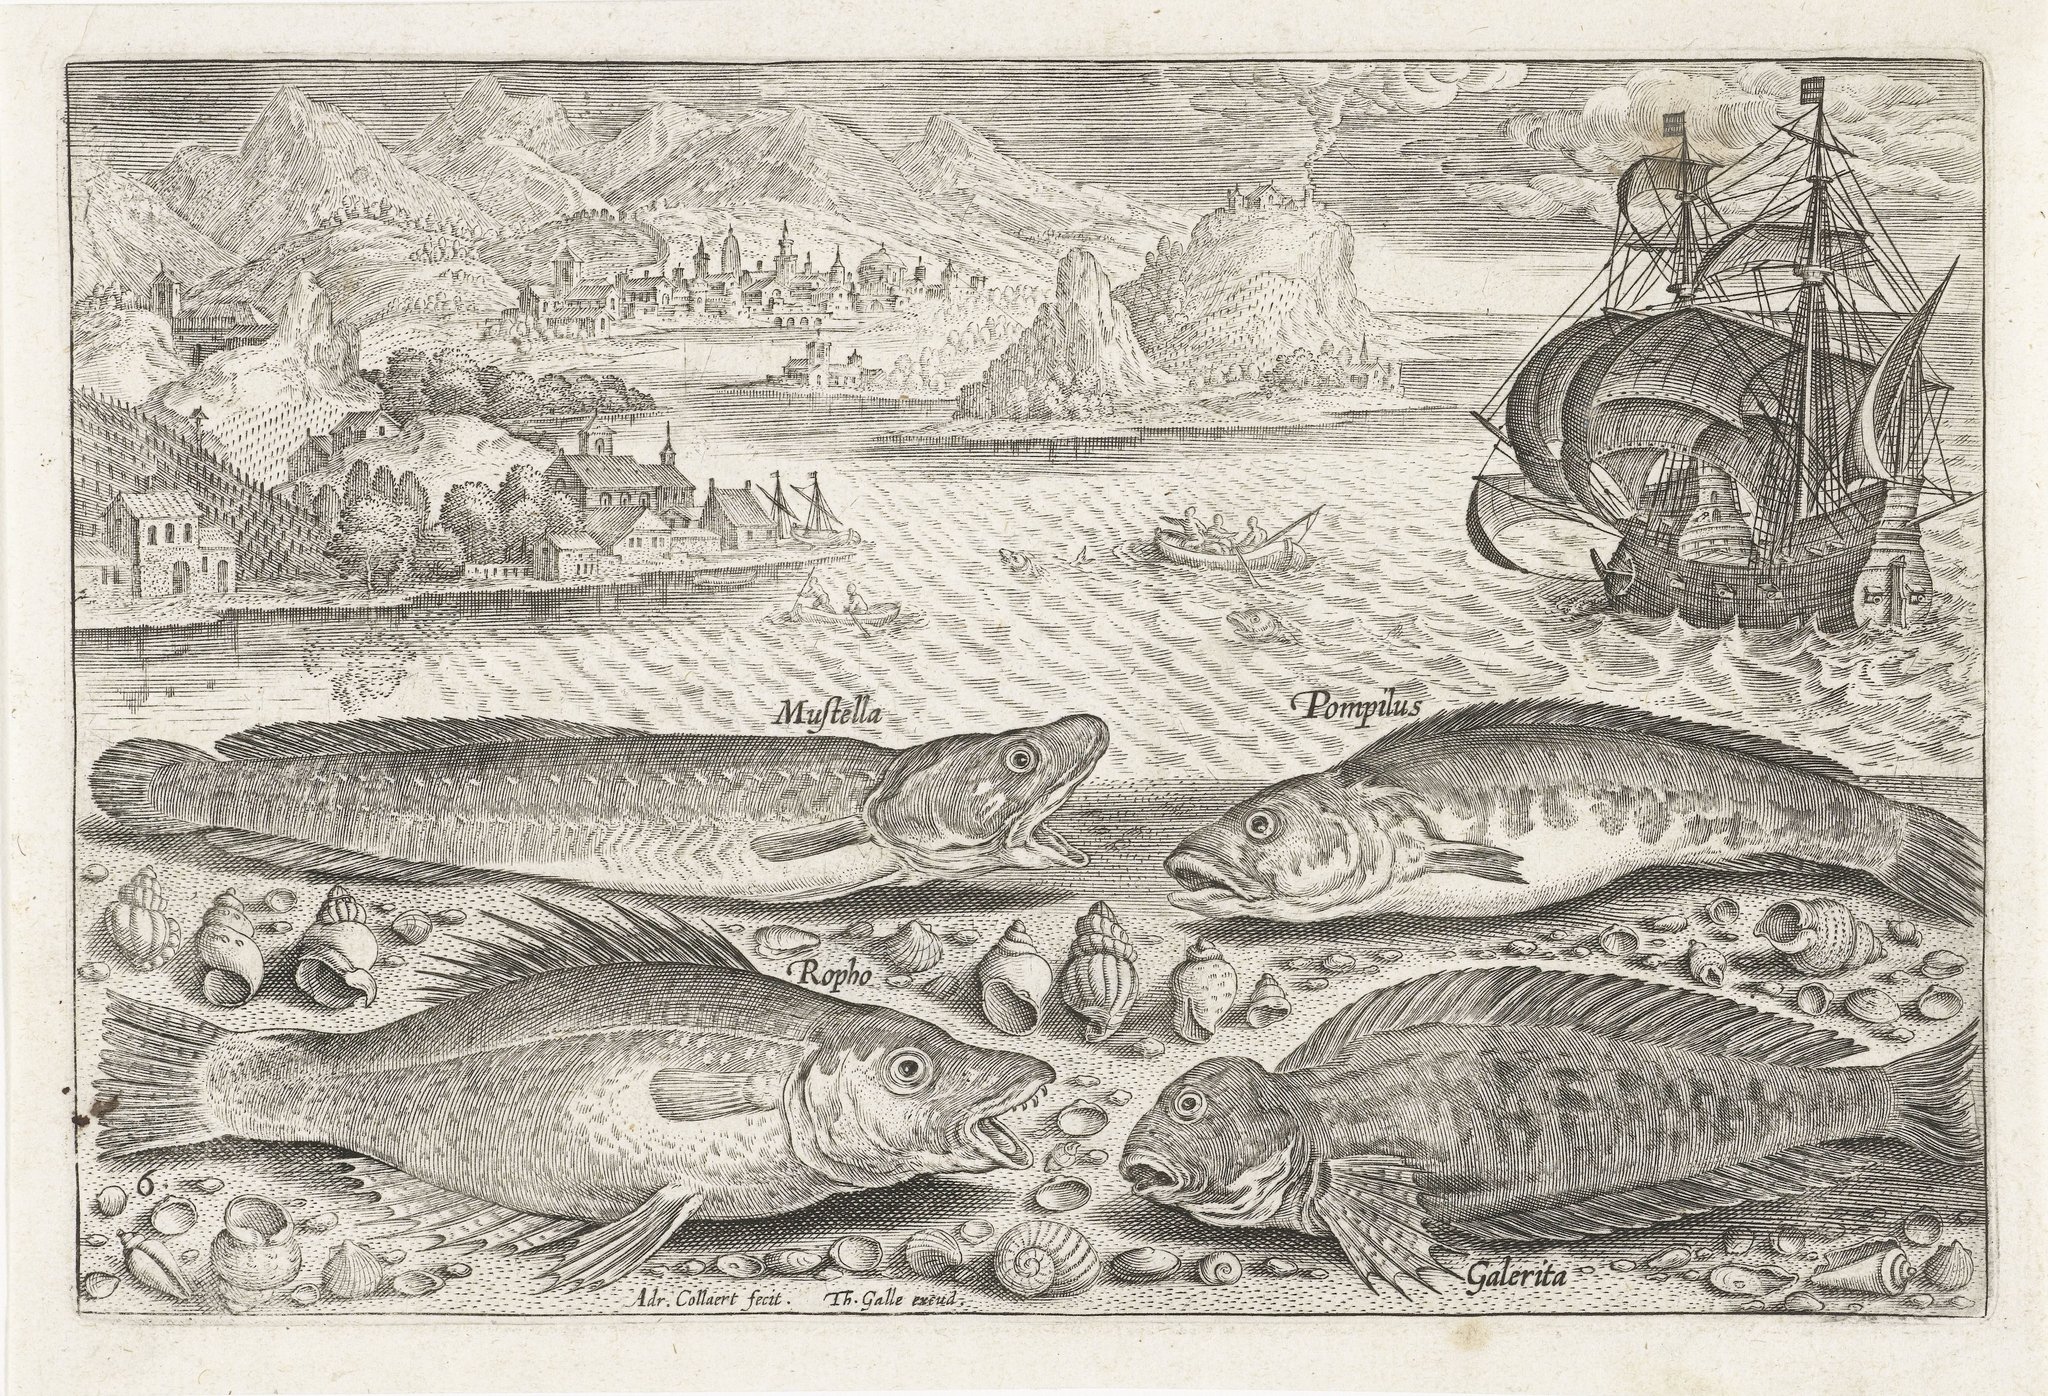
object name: print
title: Piscivm vivae icones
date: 1627-1636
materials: paper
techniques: engraving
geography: antwerp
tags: sea (seascape), bony fishes: red hake, bony fishes: sea-perch, bony fishes: blenny, bony fishes: rudderfish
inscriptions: collector's mark: Lugt 2228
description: Een gaffelkabeljauw, een tandbaars, een gehoornde slijmvis en een zwarte vis liggen samen met wat schelpen aangespoeld op het strand. Op de achtergrond de zee met wat schepen. De prent maakt deel uit van een serie met vissen als onderwerp.